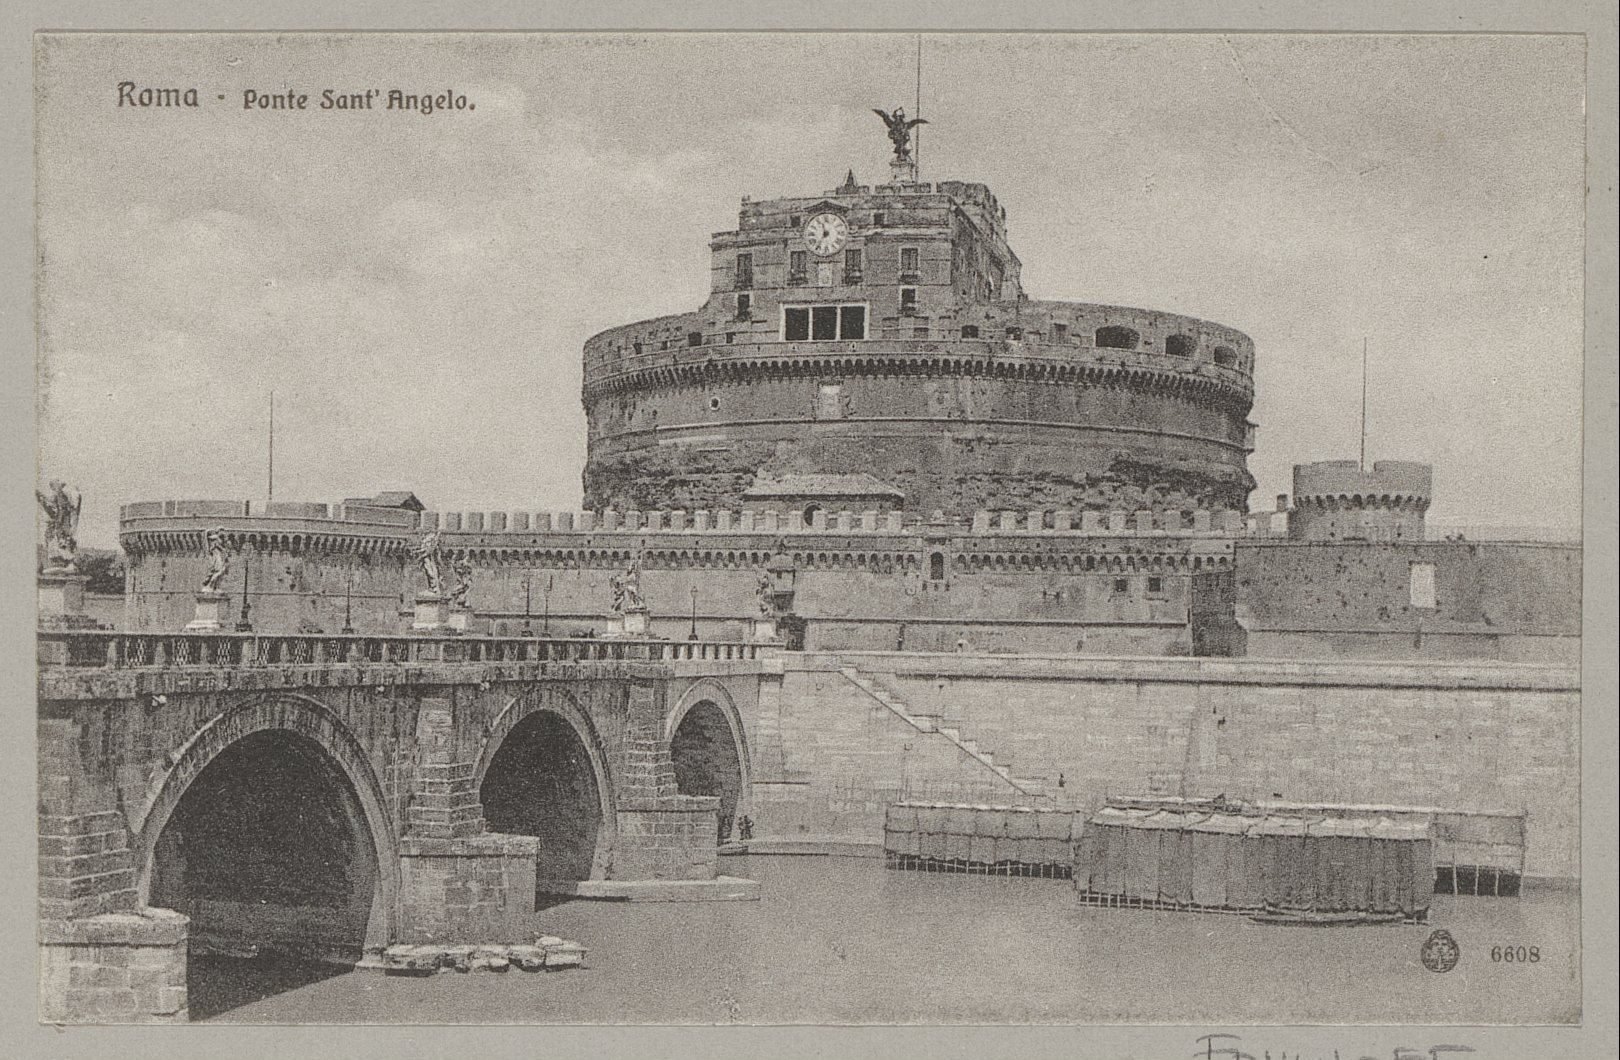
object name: ansichtkaart, prentbriefkaart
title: Roma - Ponte Sant' Angelo.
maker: Anonymous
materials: paper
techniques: photograph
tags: castle, bridge, river (+ landscape with figures, staffage)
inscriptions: inscription: ‘6608’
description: Onderdeel van Fotoalbum van een reis door Zuid-Europa en het Midden-Oosten.